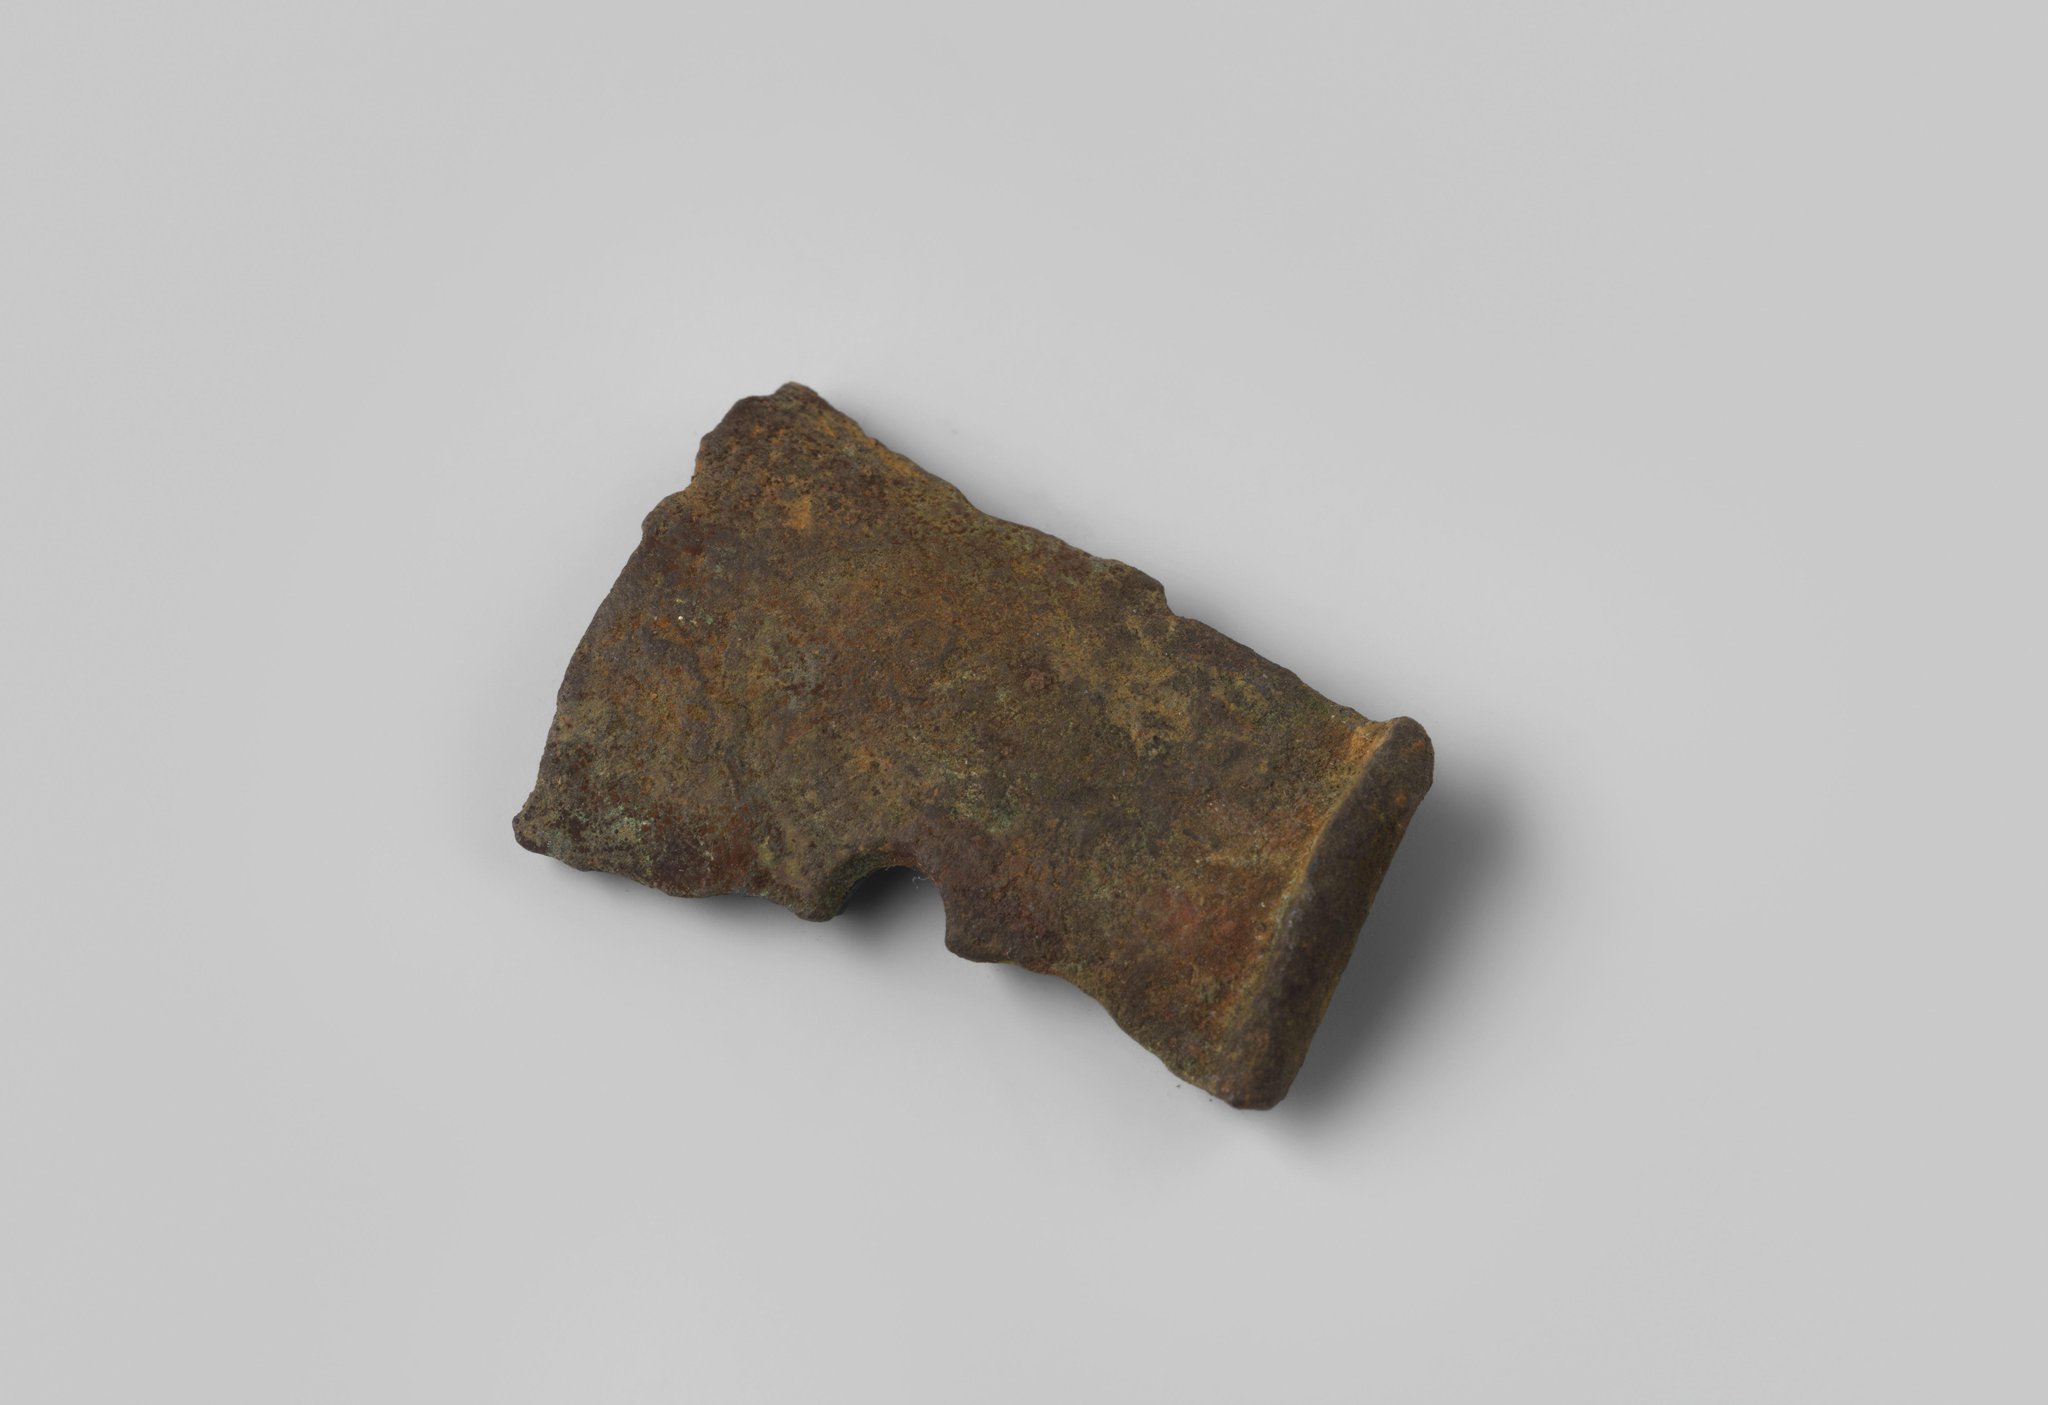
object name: koppelstuk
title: Fragment koppelstuk van een brandslang uit het wrak van de Oost-Indiëvaarder Hollandia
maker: Anonymous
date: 1700-1743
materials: copper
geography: netherlands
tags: verenigde oostindische compagnie, hollandia (schip), annet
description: Fire engine, firehose coupling; fragment, part of NG 1980-27H1891.